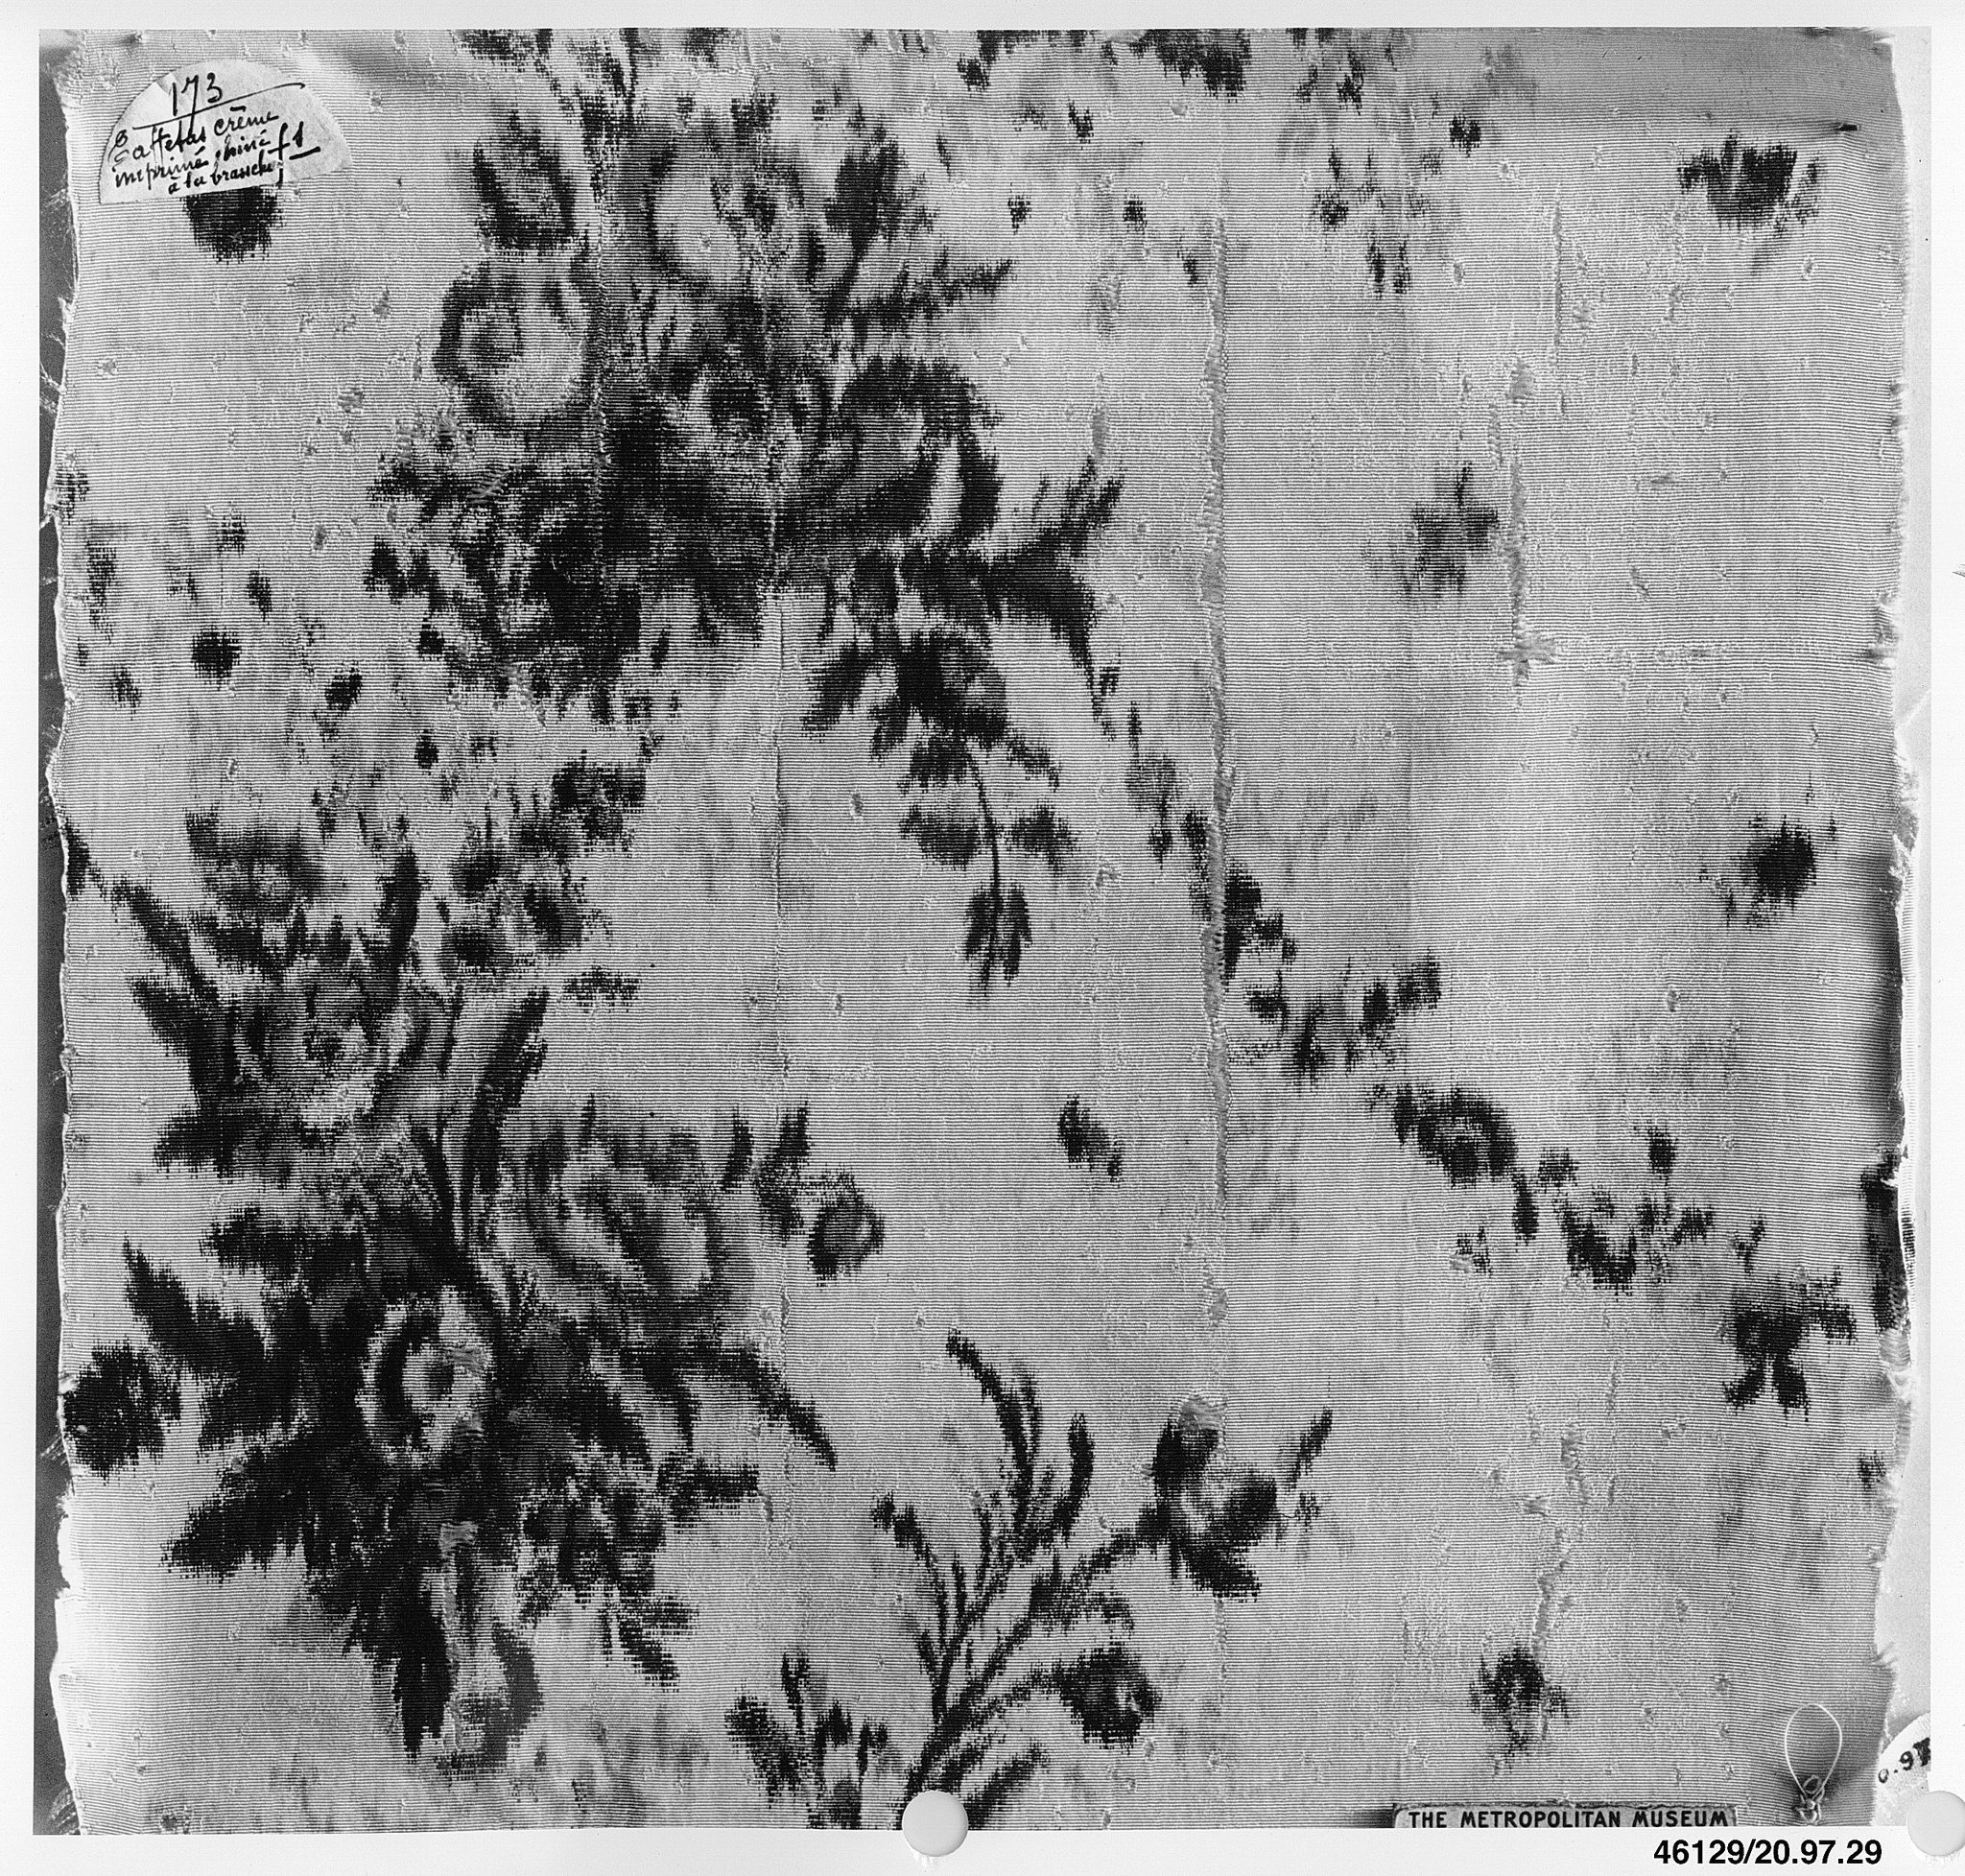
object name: piece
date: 1767-1800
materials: silk